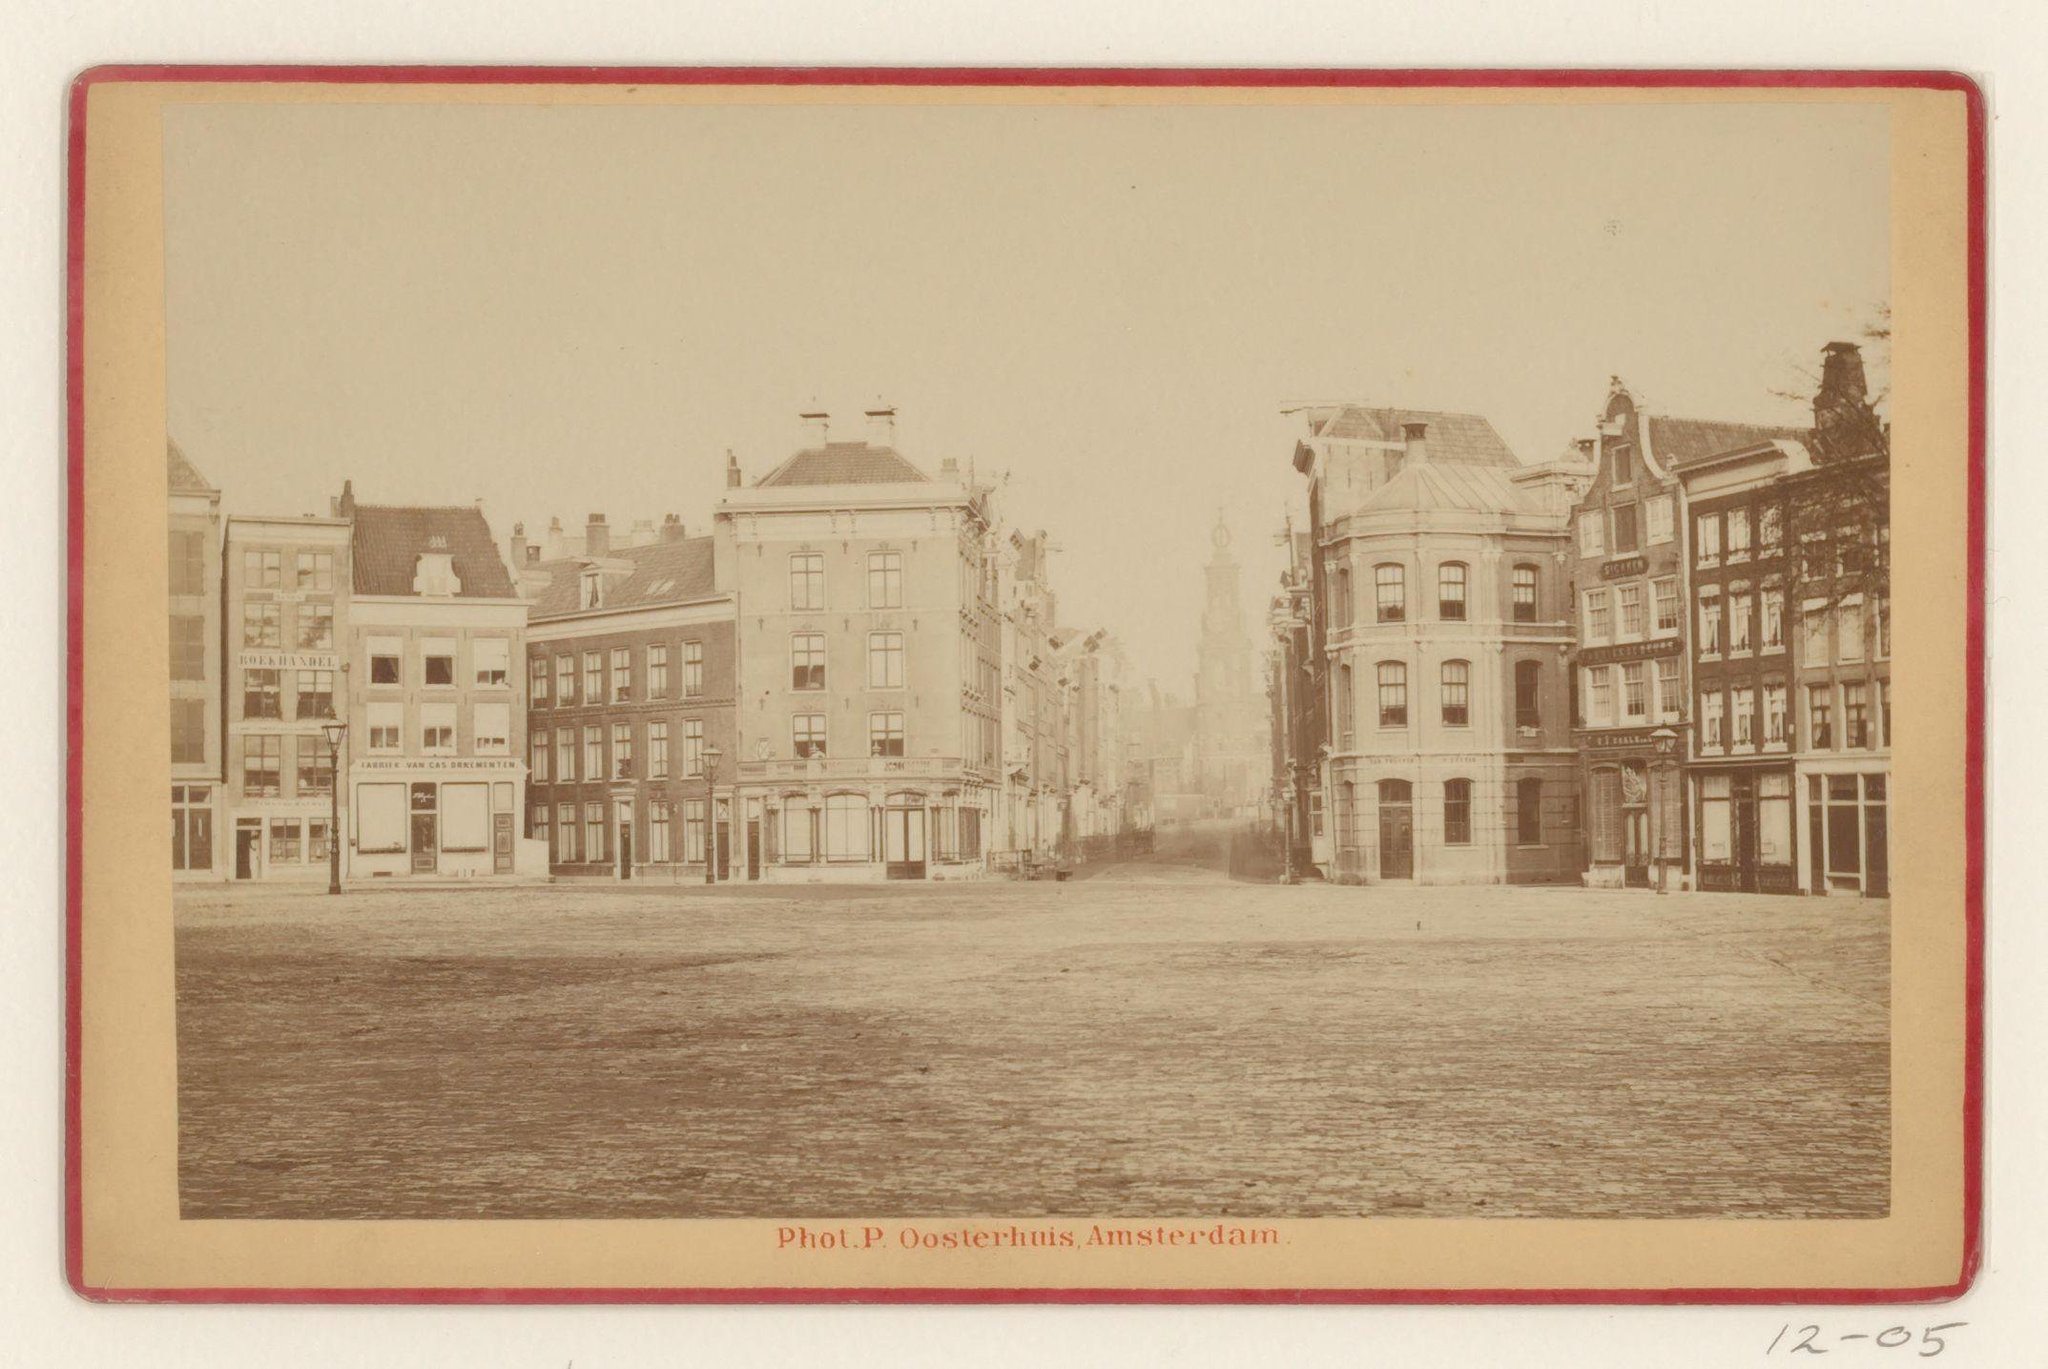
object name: cabinet photograph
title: Gezicht op het Rembrandtplein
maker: pieter oosterhuis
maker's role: draughtsman, print maker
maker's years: 1816-1885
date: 1876-1885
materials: cardboard, paper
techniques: albumen print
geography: amsterdam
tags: square, place, circus, etc., tower, clock tower ~ monumental adornment, city-view in general; 'veduta', façade (of house or building), street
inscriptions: inscription: ‘Rembrandtplein.’, collector's mark: ‘12,5’ Lugt 1641b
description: Onderwerpsrubriek binnen de Atlas Amsterdam: Rembrandtplein (Botermarkt), Roeterseiland.